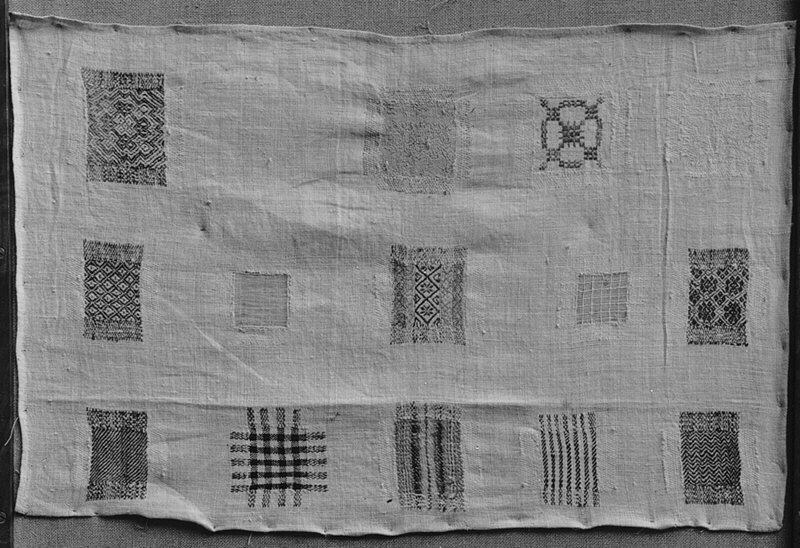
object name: sampler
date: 1801-1833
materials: linen, silk